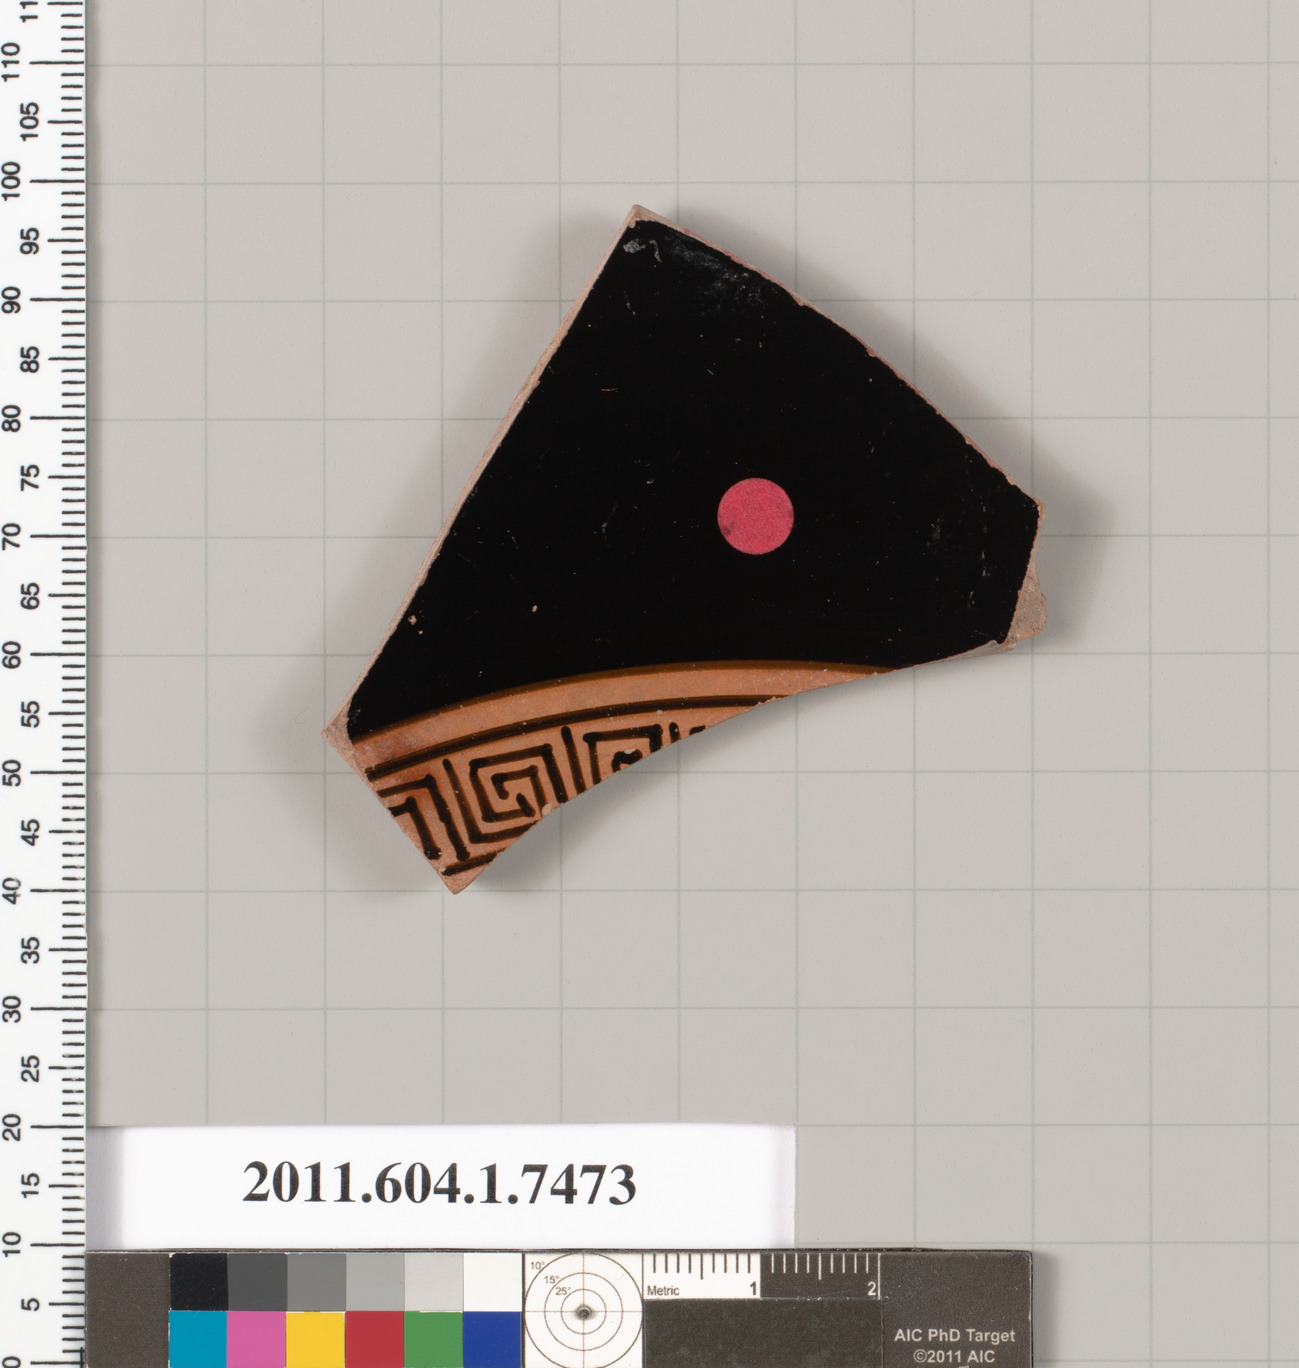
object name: kylix fragment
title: Terracotta fragment of a kylix (drinking cup)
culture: greek, attic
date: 470-460 BCE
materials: terracotta